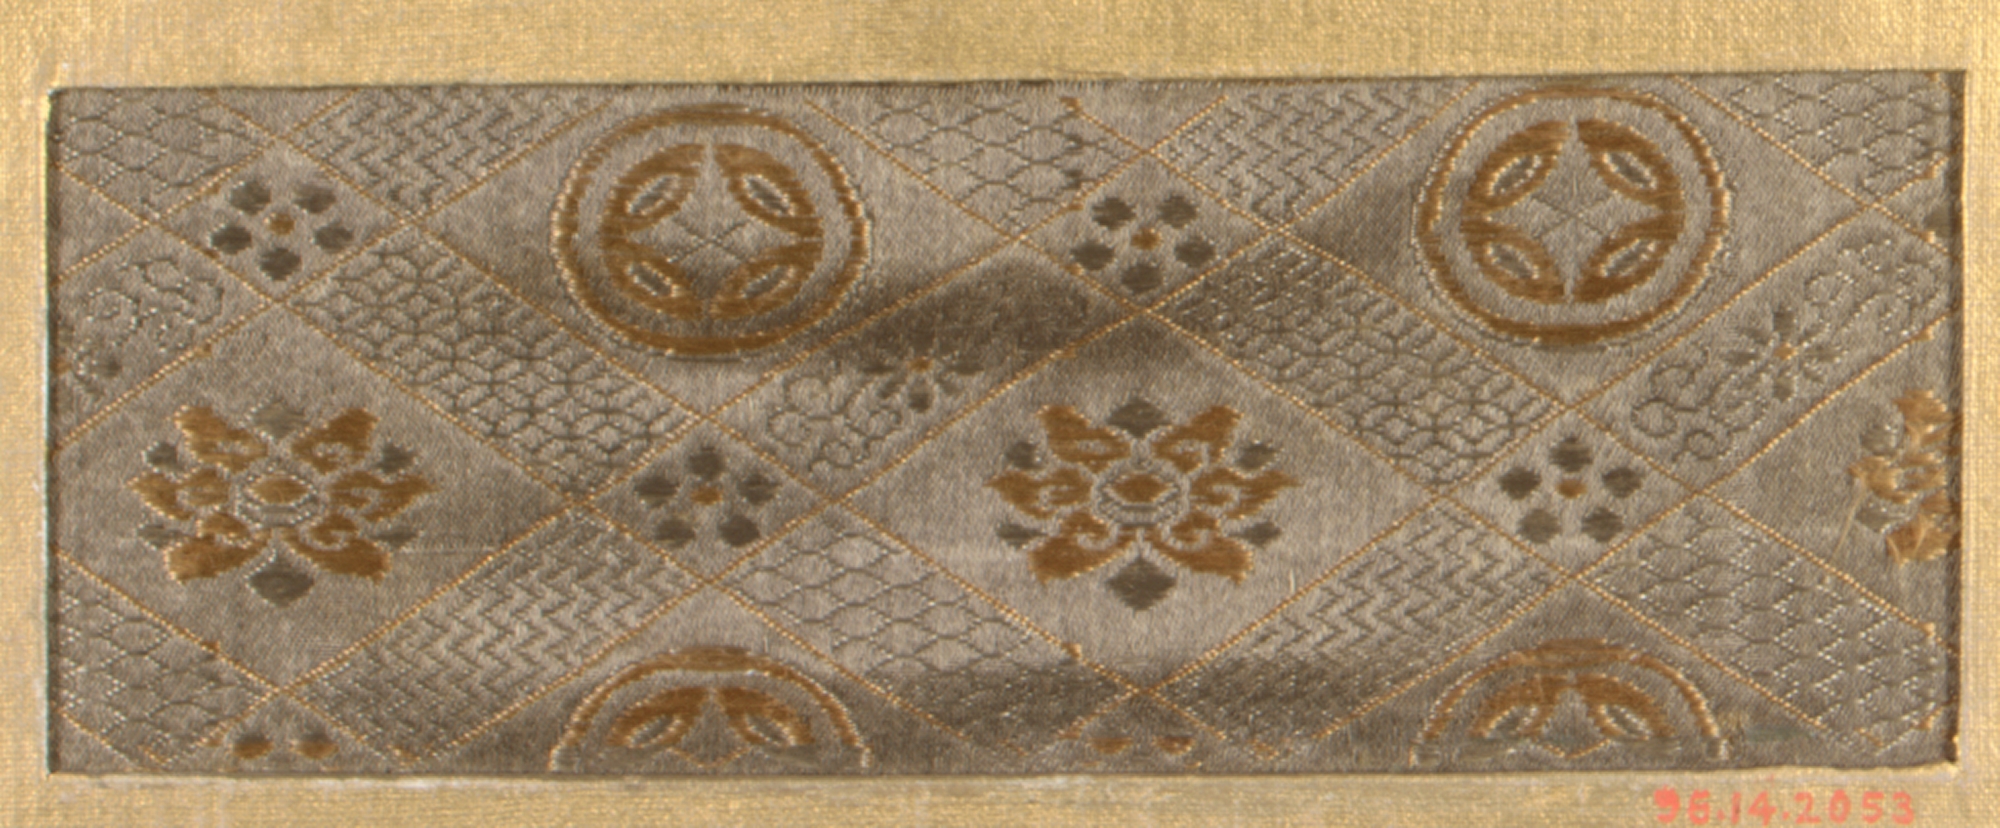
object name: piece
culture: japanese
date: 1701-1900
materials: silk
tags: flowers